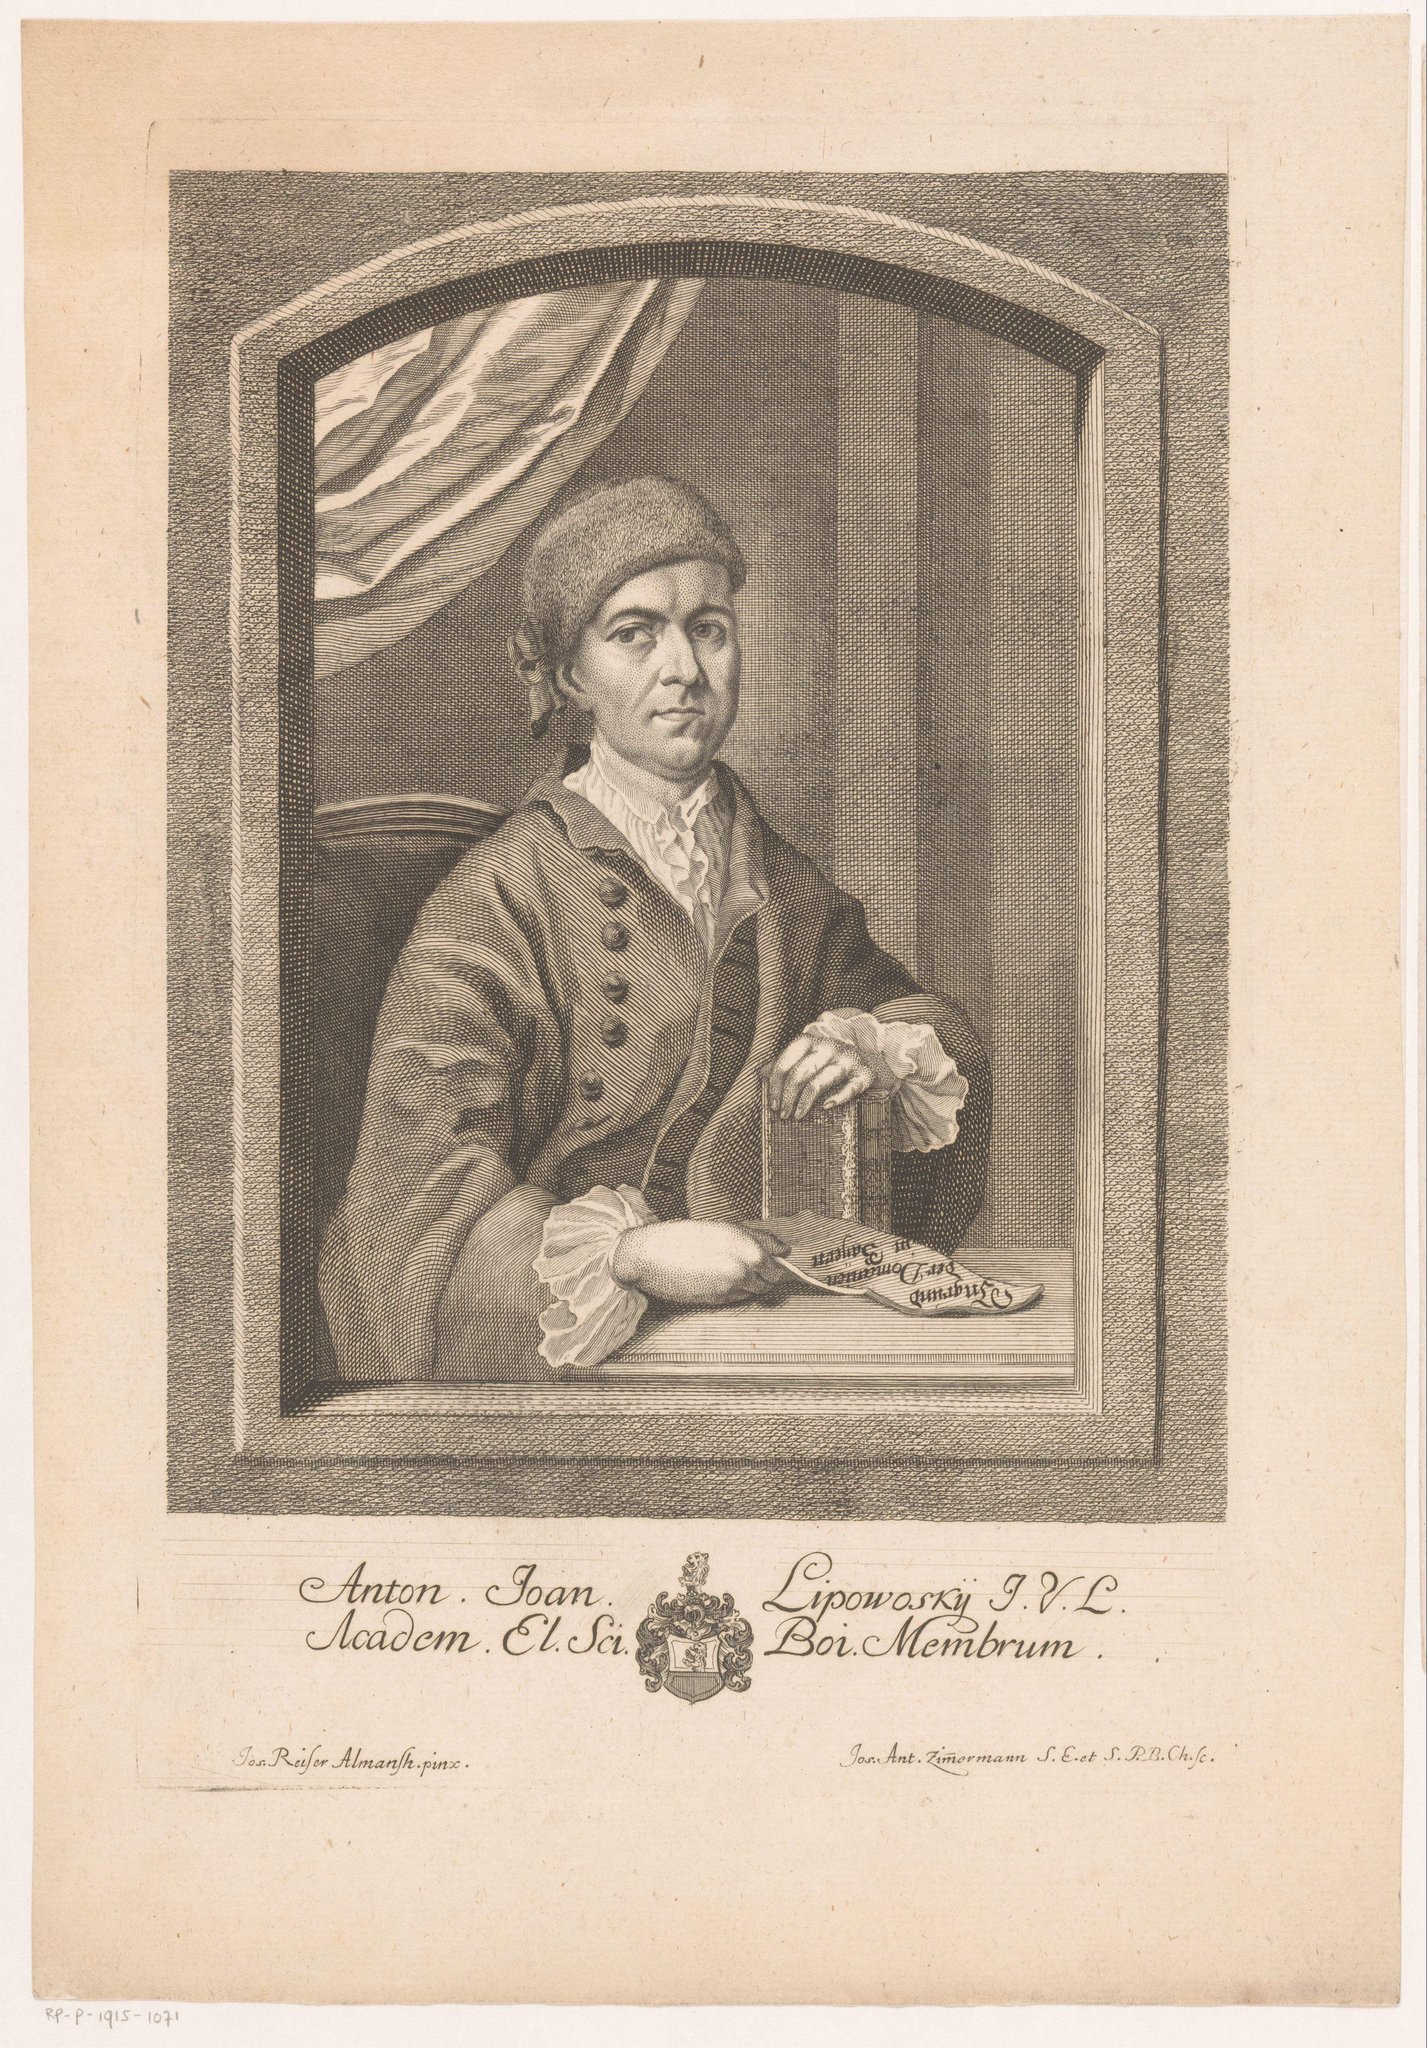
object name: print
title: Portret van Anton Lipowsky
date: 1755-1797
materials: paper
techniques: engraving, etching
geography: germany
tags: historical persons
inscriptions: collector's mark: Lugt 2228